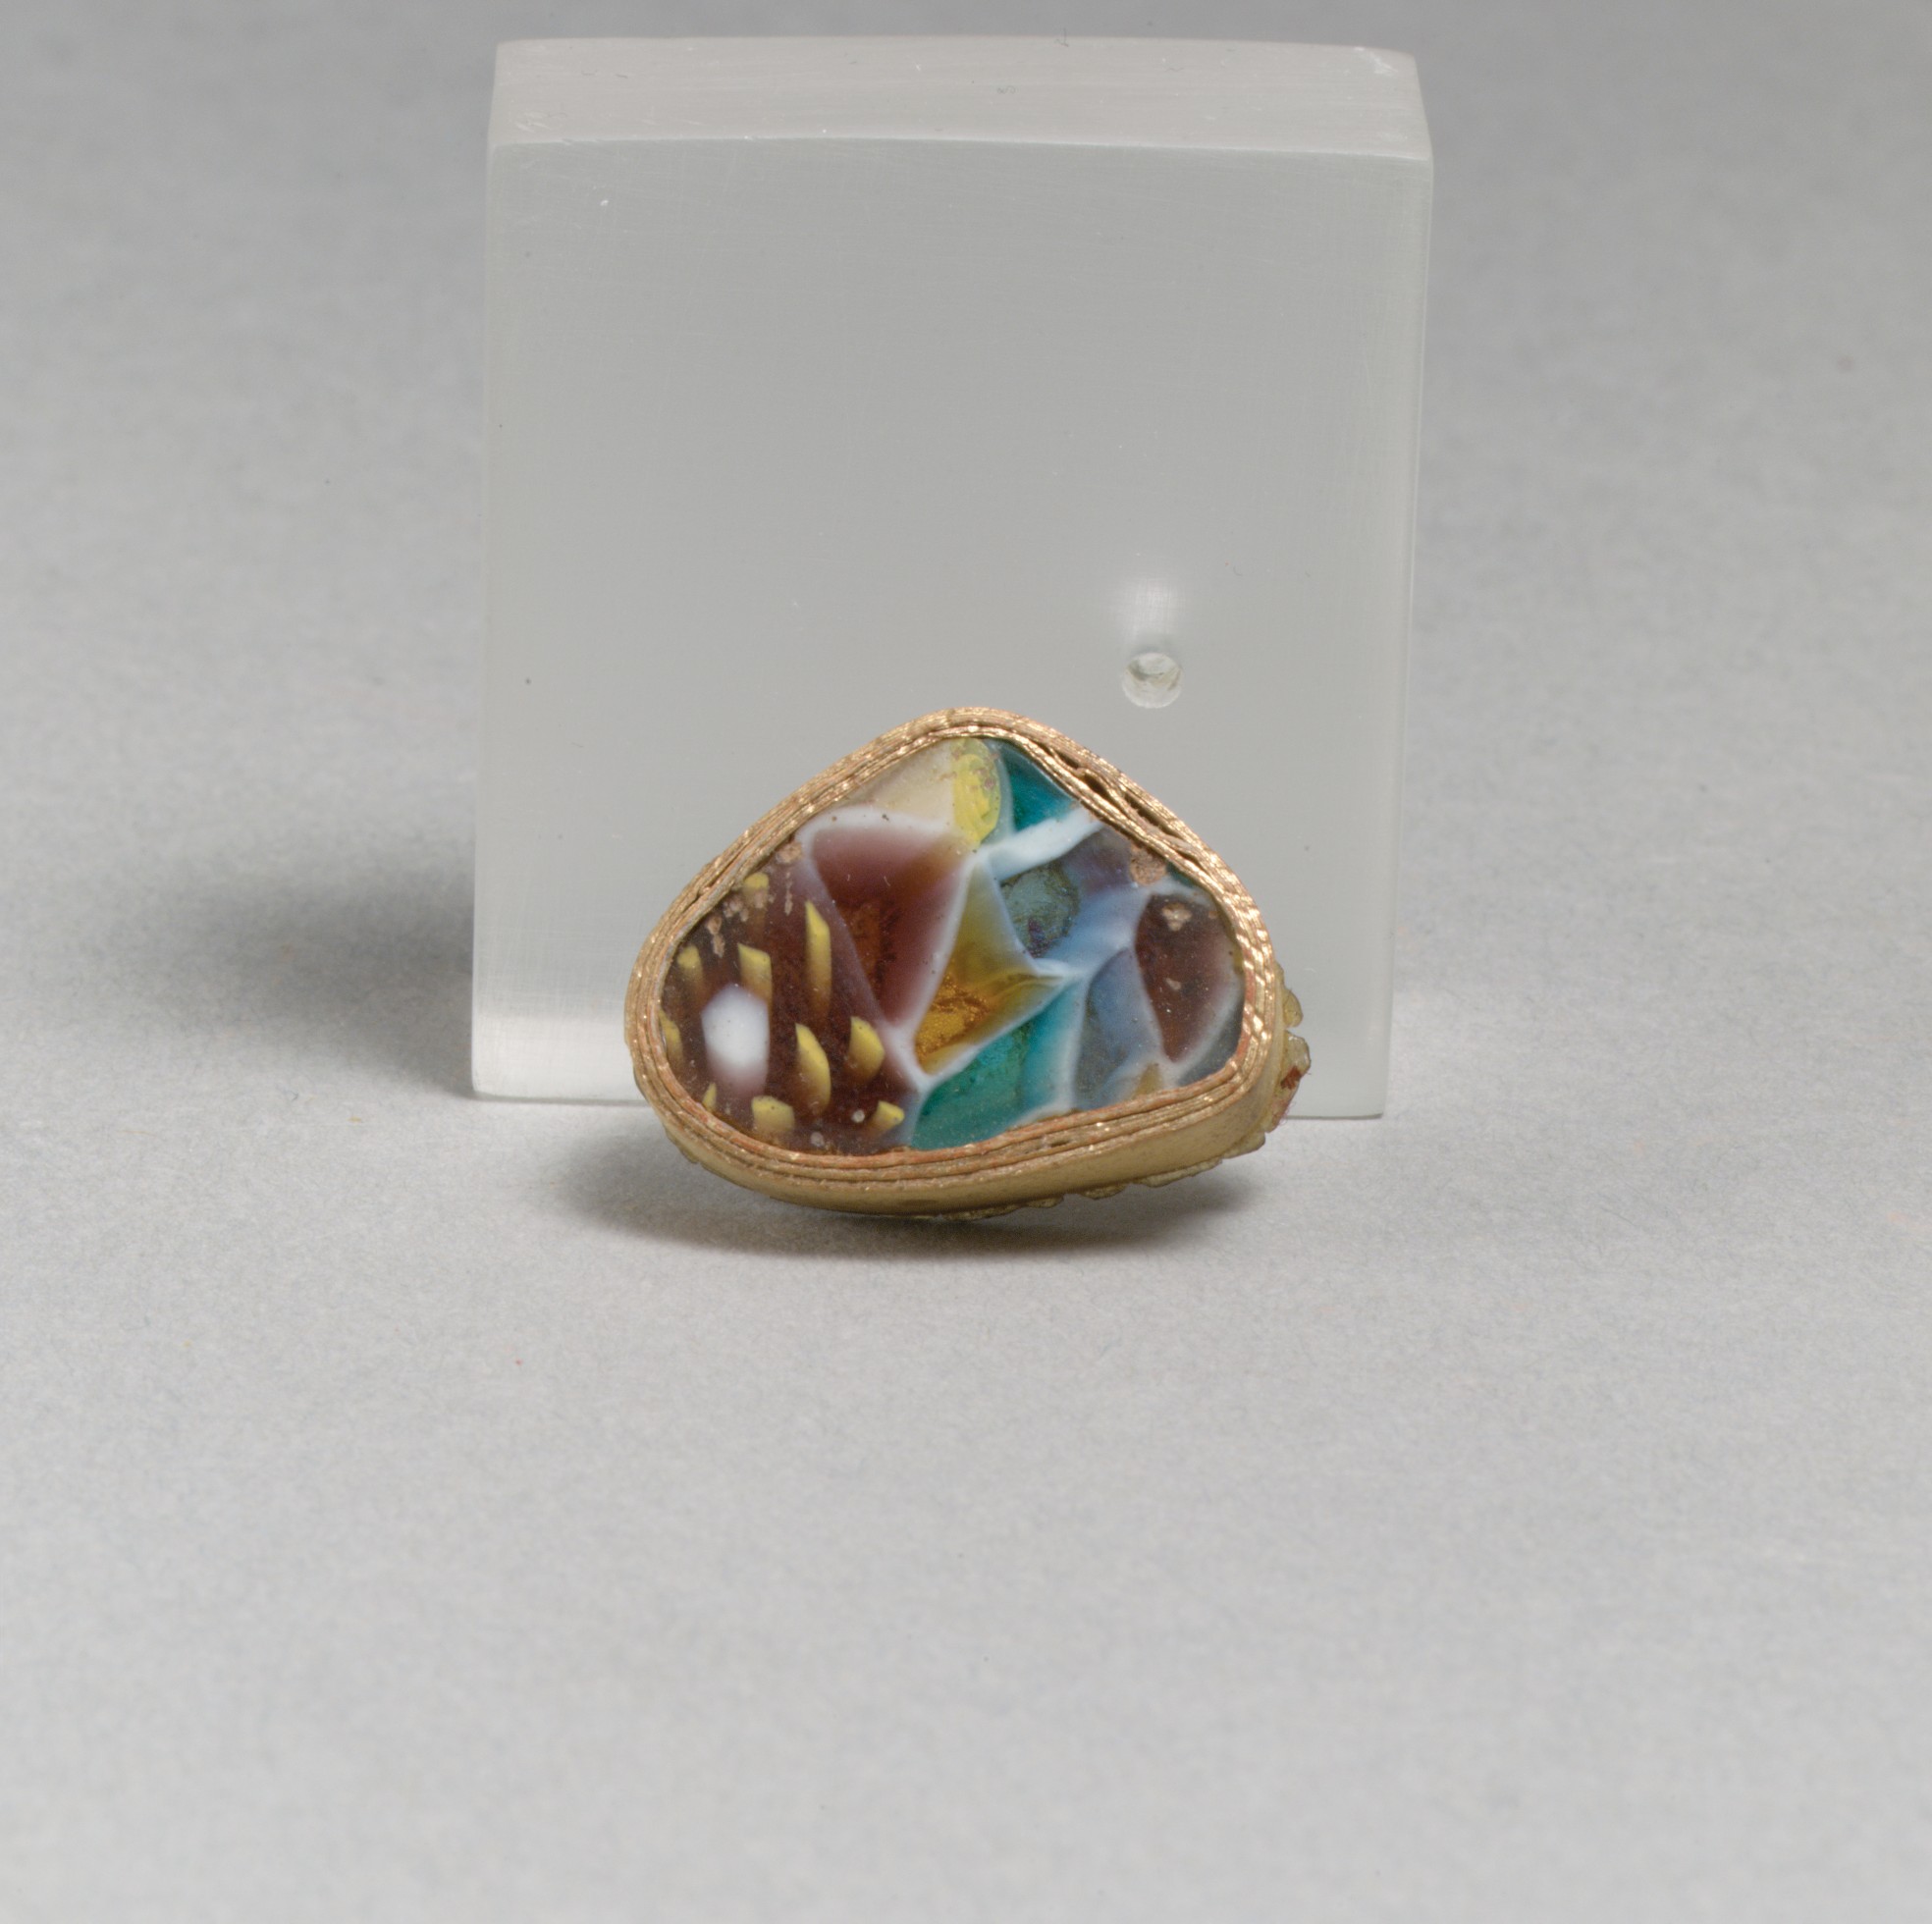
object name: fragment, mosaic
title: Glass mosaic fragment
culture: roman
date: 34 BCE-33 CE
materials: glass